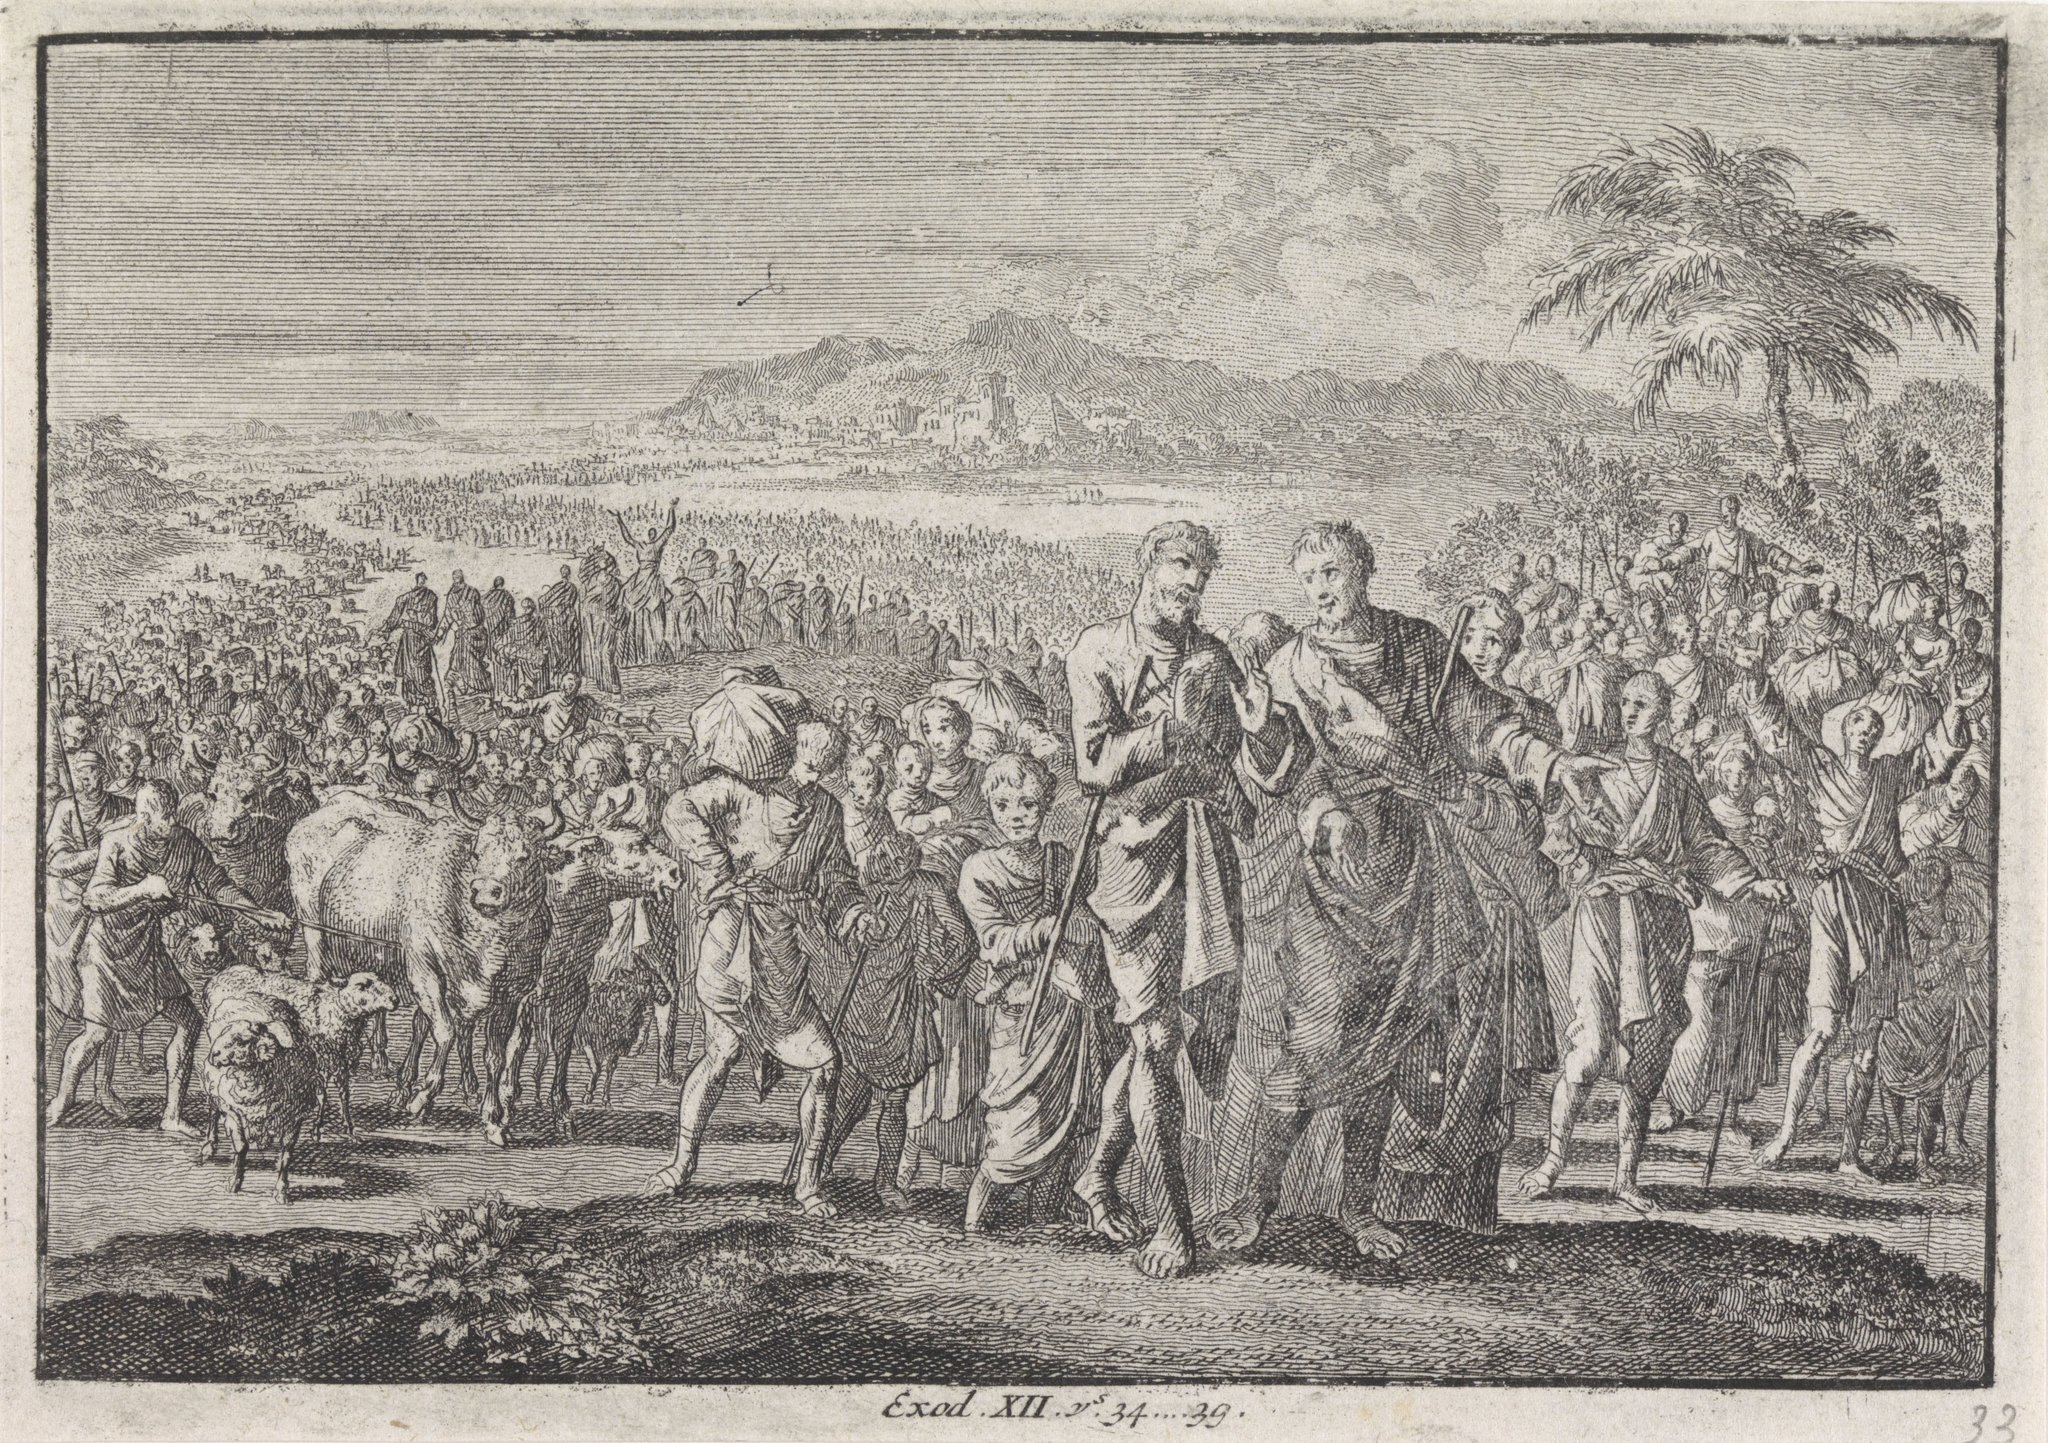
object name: print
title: Uittocht uit Egypte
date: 1703-1762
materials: paper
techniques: etching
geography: amsterdam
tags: the israelites leave egypt; first movement from rameses to succoth (exodus 12:31 - 13:16)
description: De prent komt een eerste keer voor als boekillustratie voor David Martin. Historie des Ouden en Nieuwen Testaments. Amsterdam, Pieter Mortier, 1703. Deel I. De boekillustraties voor de Mortierbijbel hebben verschillende staten en kopieën, waarbij de chronologische volgorde moeilijk te achterhalen valt. Als boekillustraties werden ze bovendien herhaaldelijk opnieuw gebruikt voor andere boekwerken.